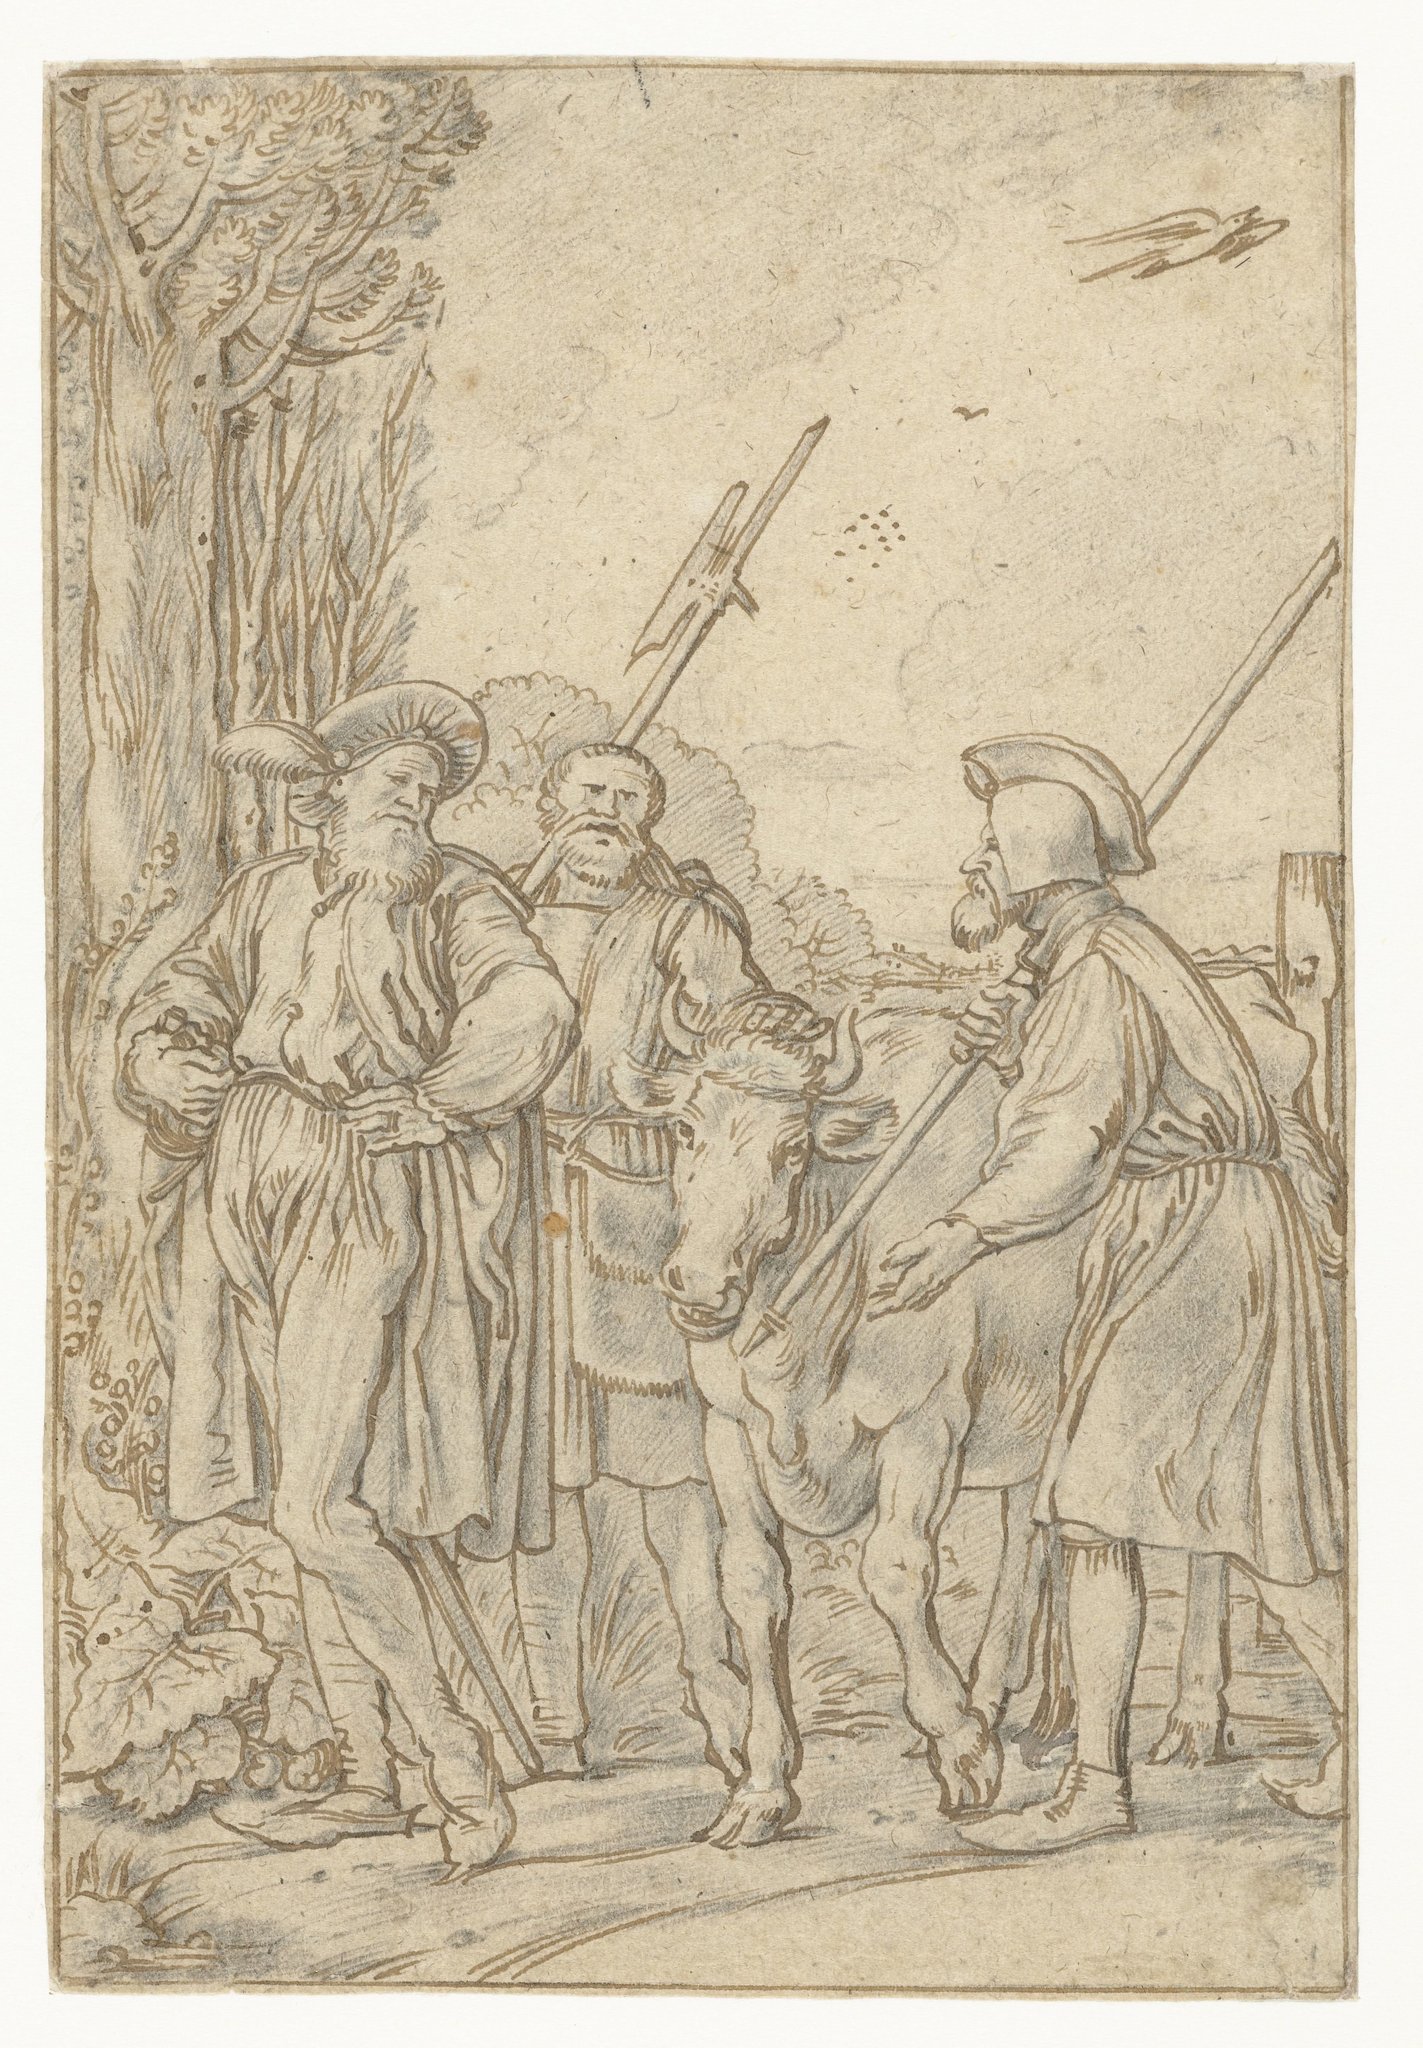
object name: drawing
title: De rechtspraak van Graaf Willem III de Goede, tweede reeks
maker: willem pietersz buytewech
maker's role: draughtsman, print maker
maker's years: 1592-1624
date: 1619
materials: chalk, ink, paper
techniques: pen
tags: cow